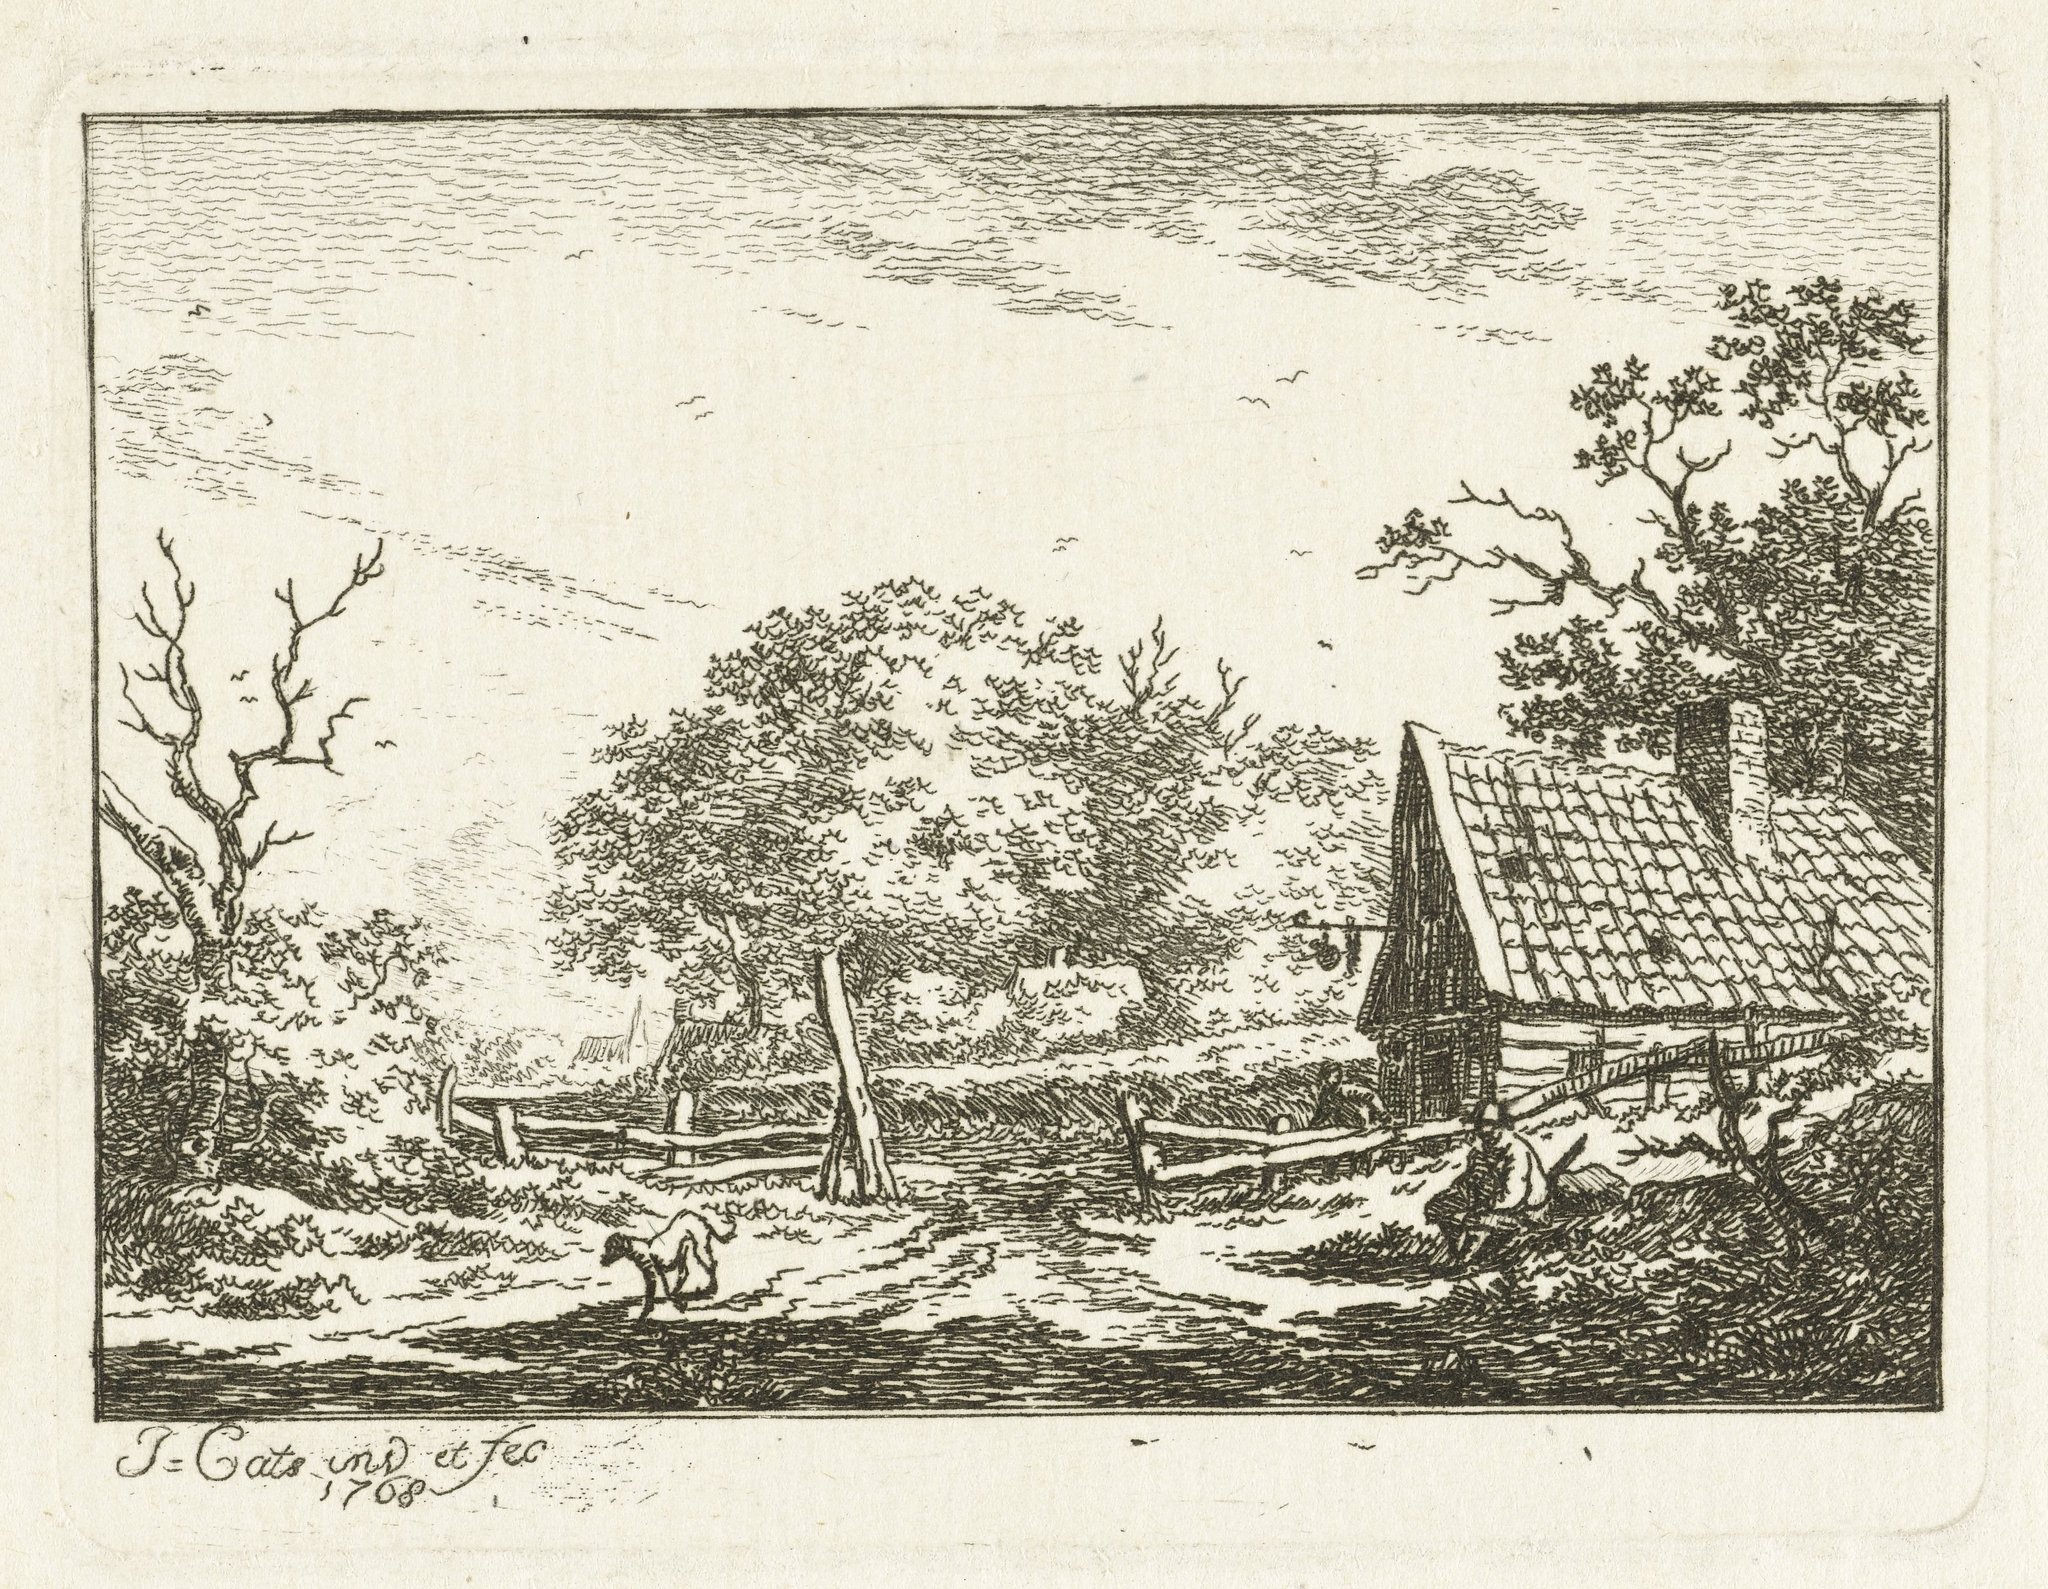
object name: print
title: Landschap met zittende man en hond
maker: jacob cats (1741-1799)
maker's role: draughtsman, print maker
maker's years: 1741-1799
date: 1768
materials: paper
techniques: etching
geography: amsterdam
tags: landscapes, dog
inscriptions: collector's mark: Lugt 2228